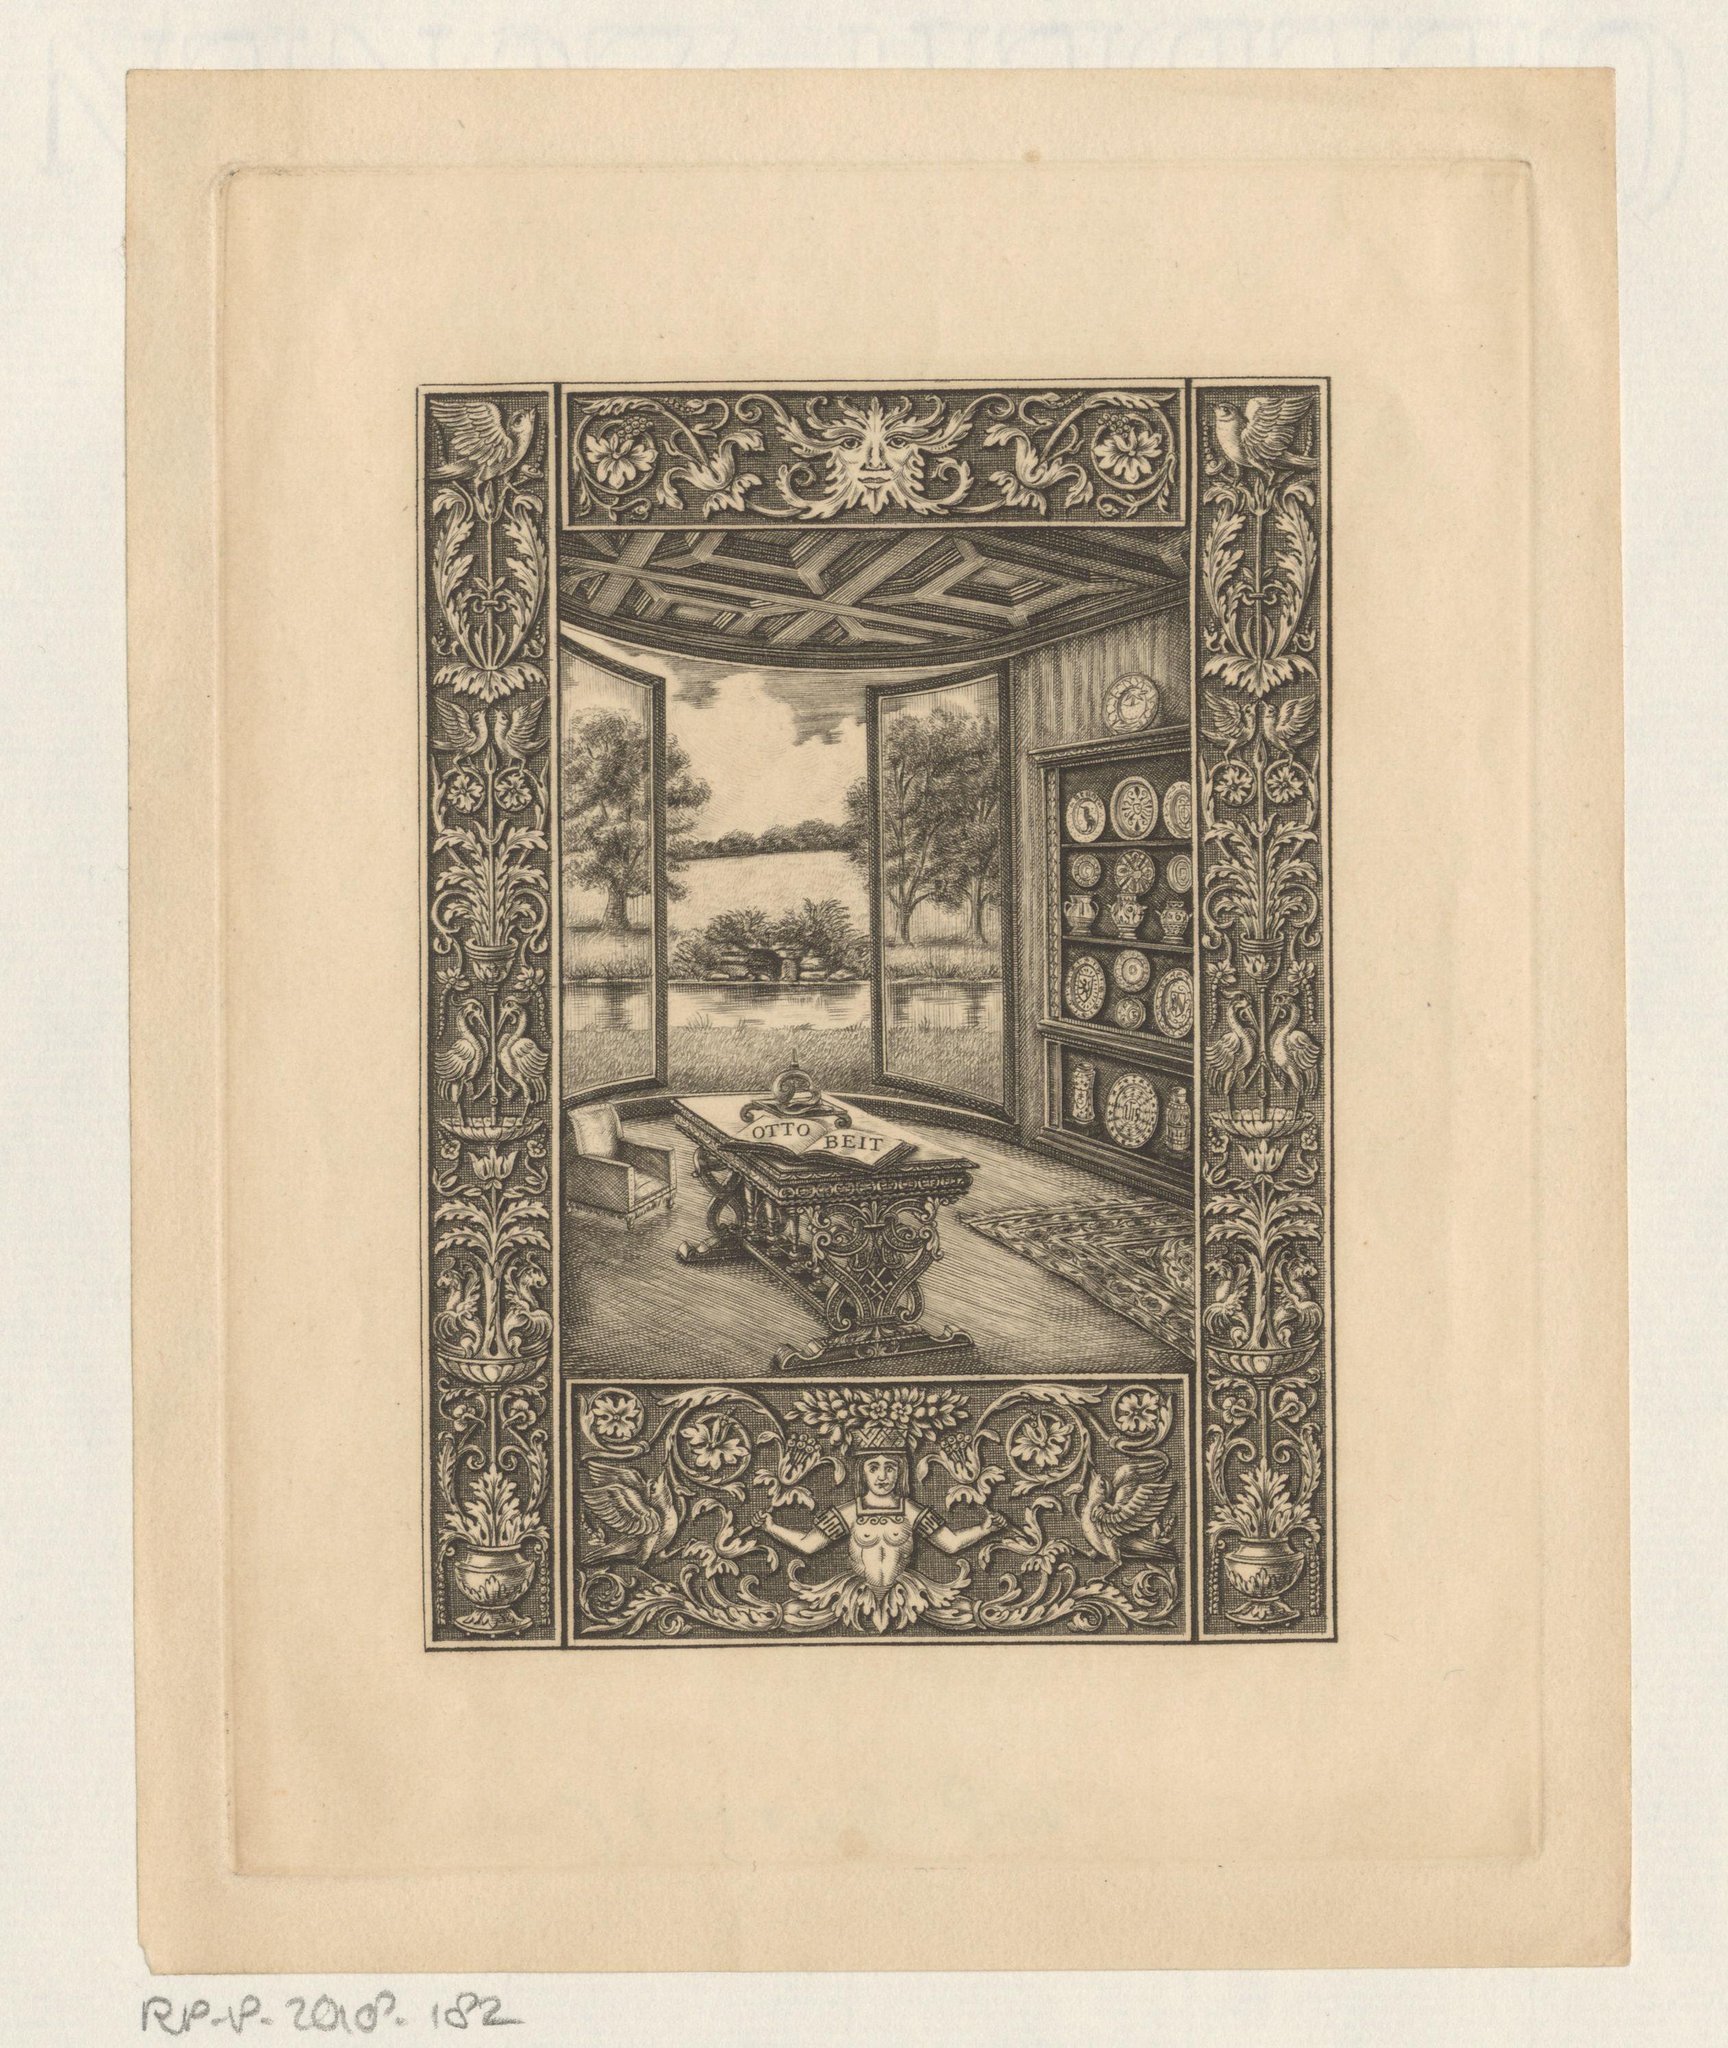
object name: bookplate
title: Ex libris van Otto Beit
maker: william phillips barrett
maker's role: print maker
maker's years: 1861-1938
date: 1875-1930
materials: paper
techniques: engraving, etching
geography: england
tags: garden, open window, living-room, parlour, sitting-room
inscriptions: inscription: ‘W.P. Barrett’